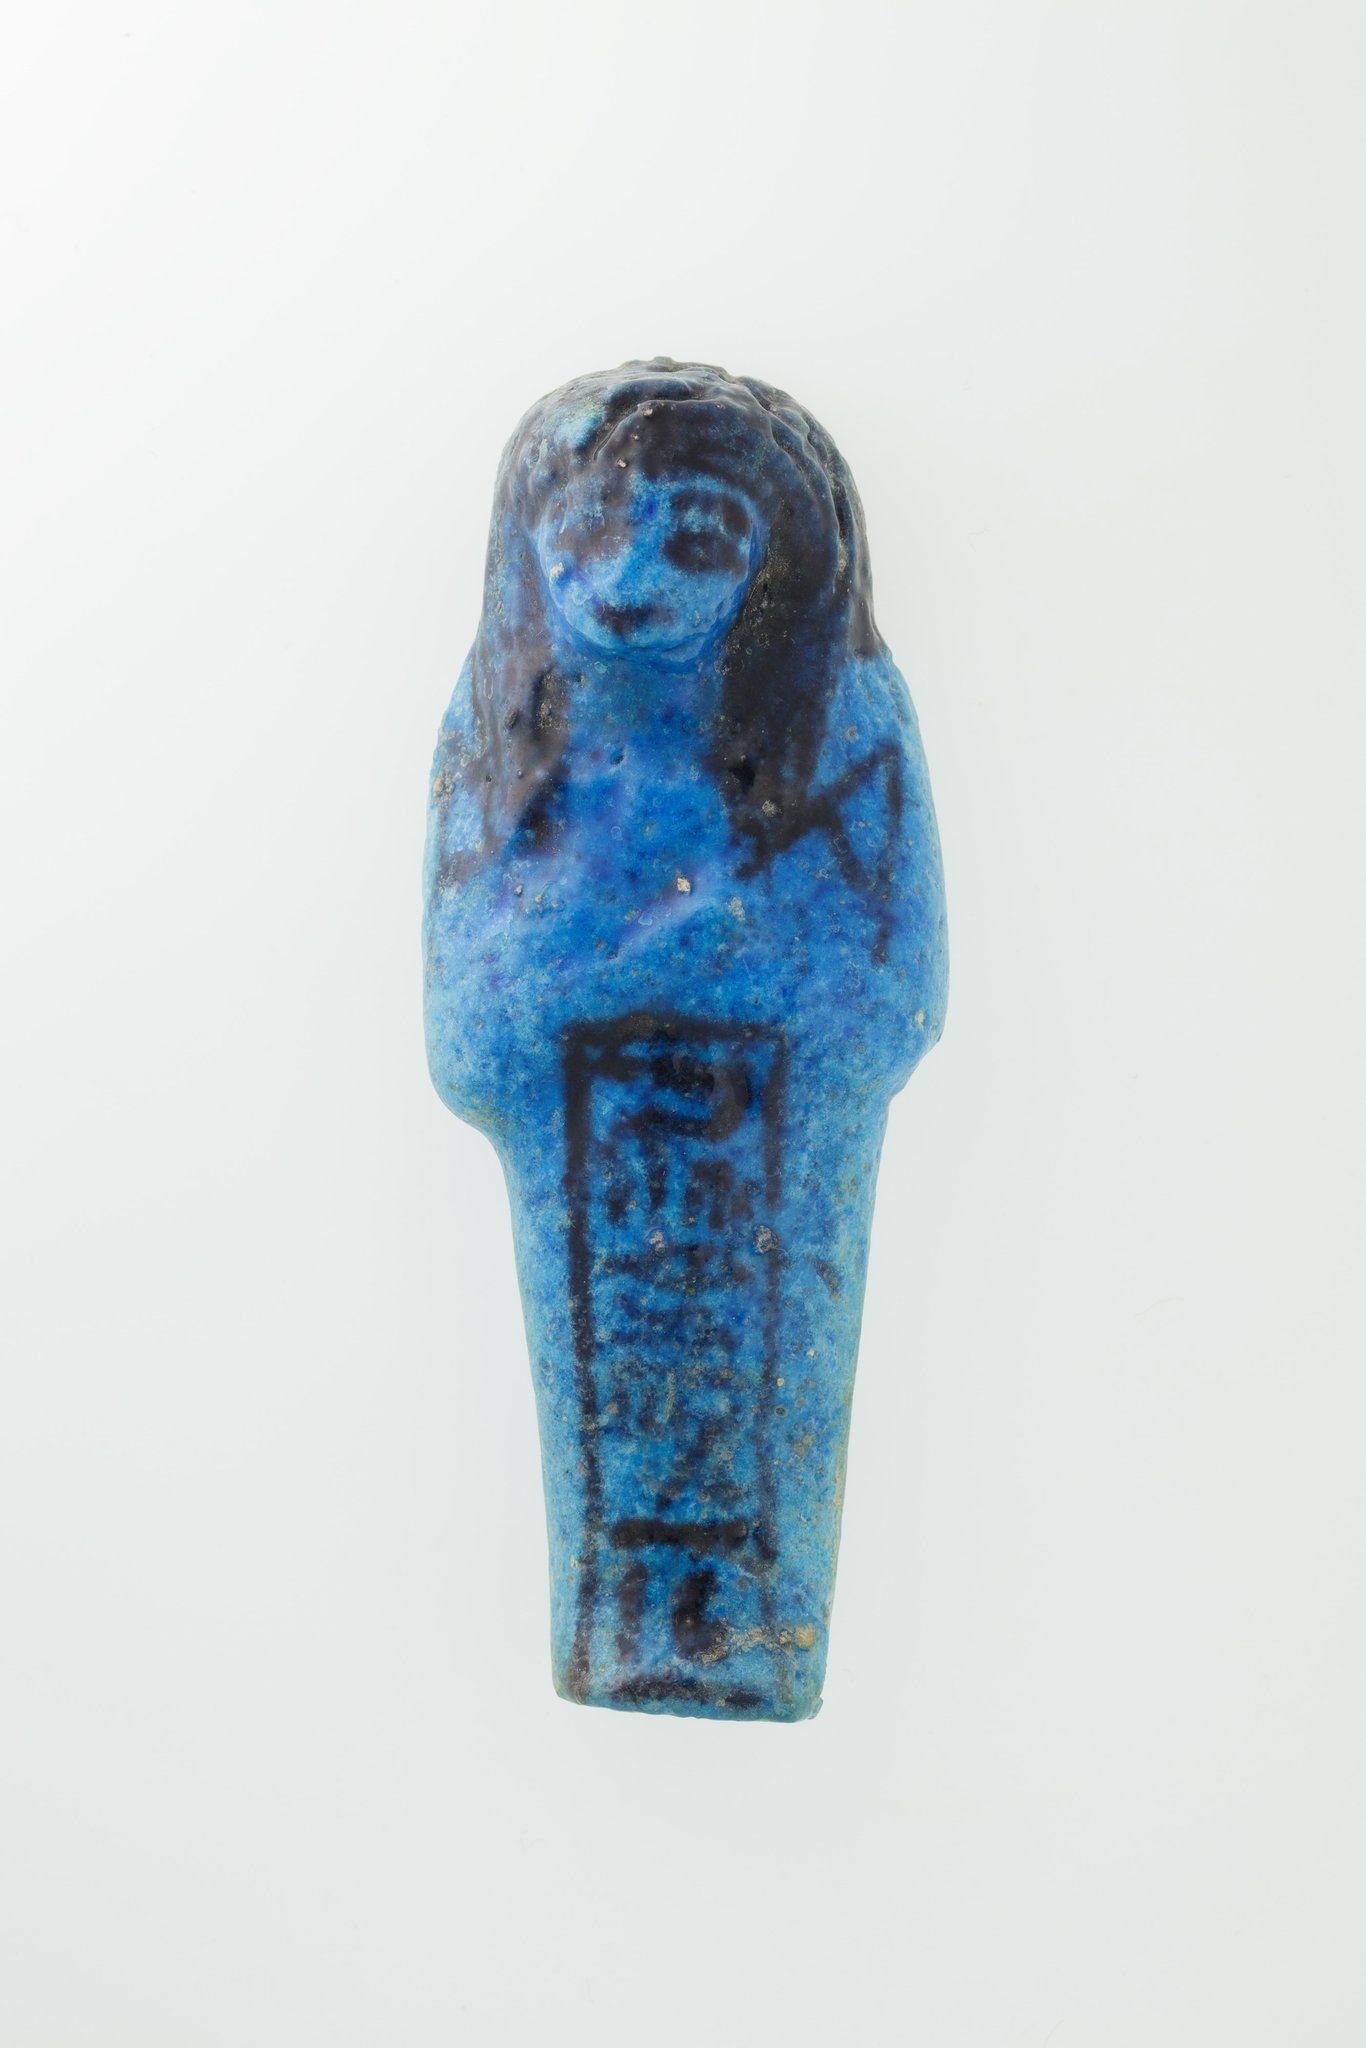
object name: shabti, worker, nauny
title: Worker Shabti of Nauny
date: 1050 BCE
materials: faience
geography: egypt